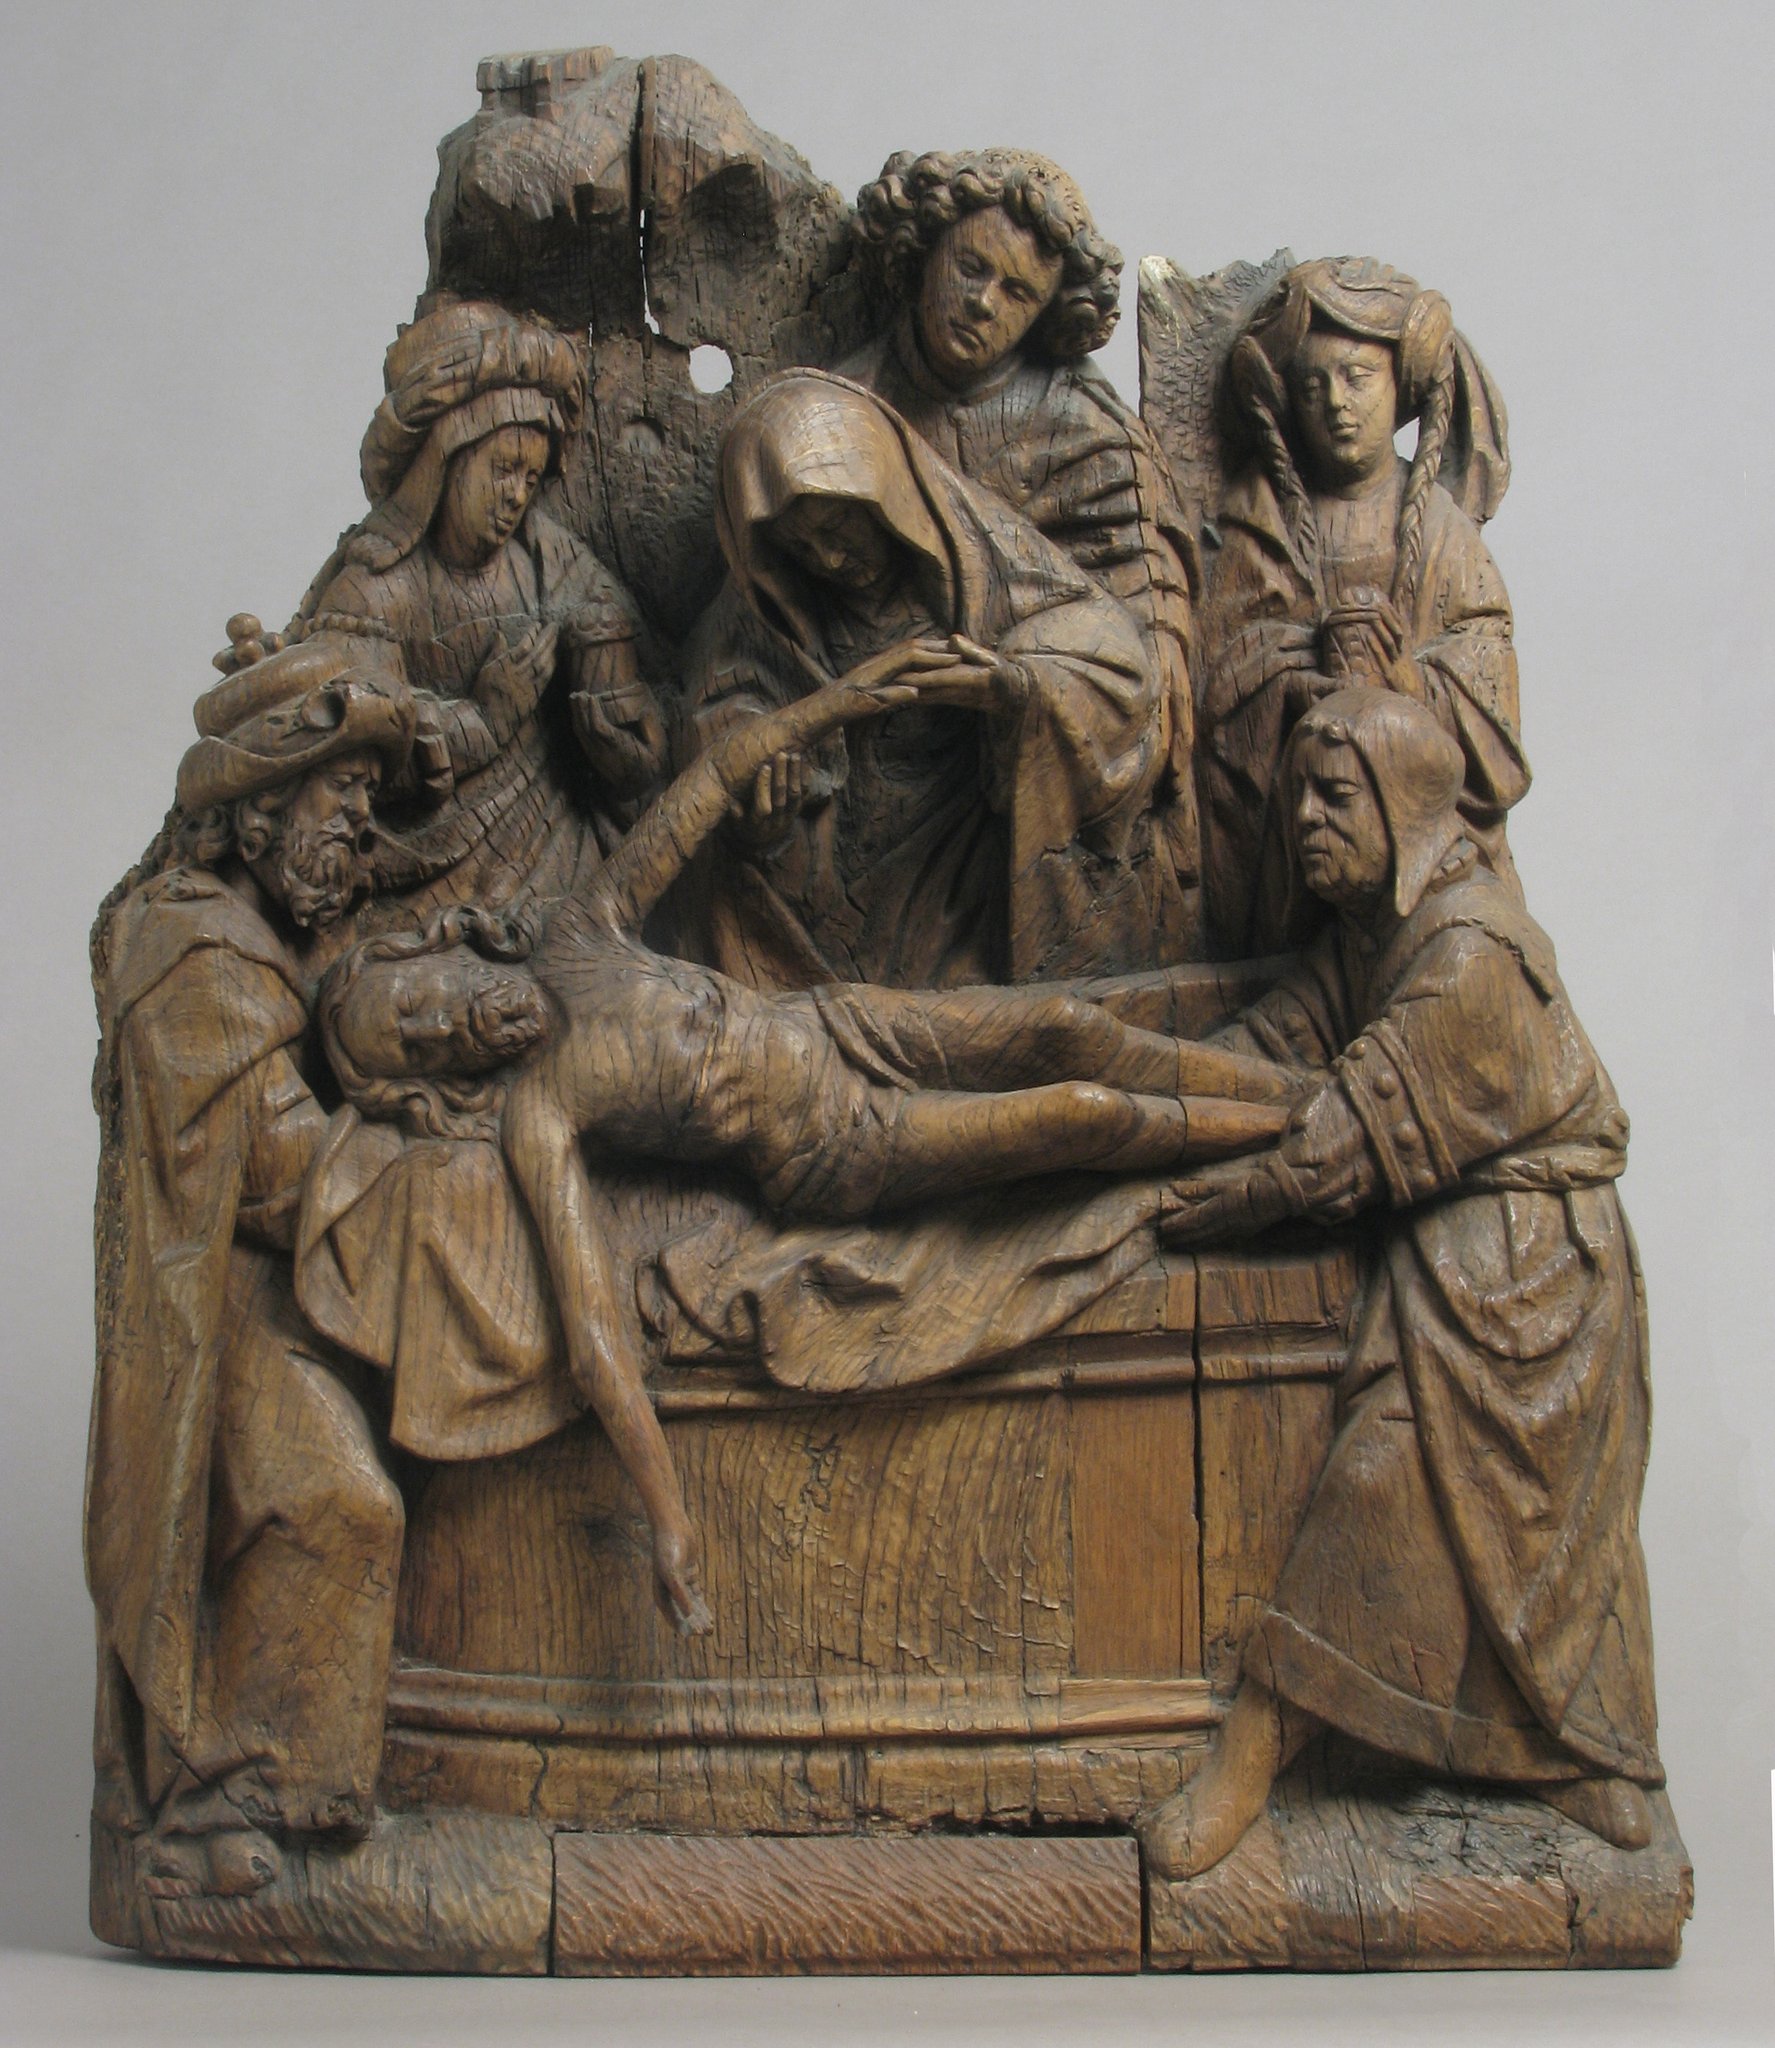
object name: relief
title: The Entombment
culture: south netherlandish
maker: school of antwerp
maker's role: artist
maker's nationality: south netherlandish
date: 1501-1533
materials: wood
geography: belgium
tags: men,christ,virgin mary